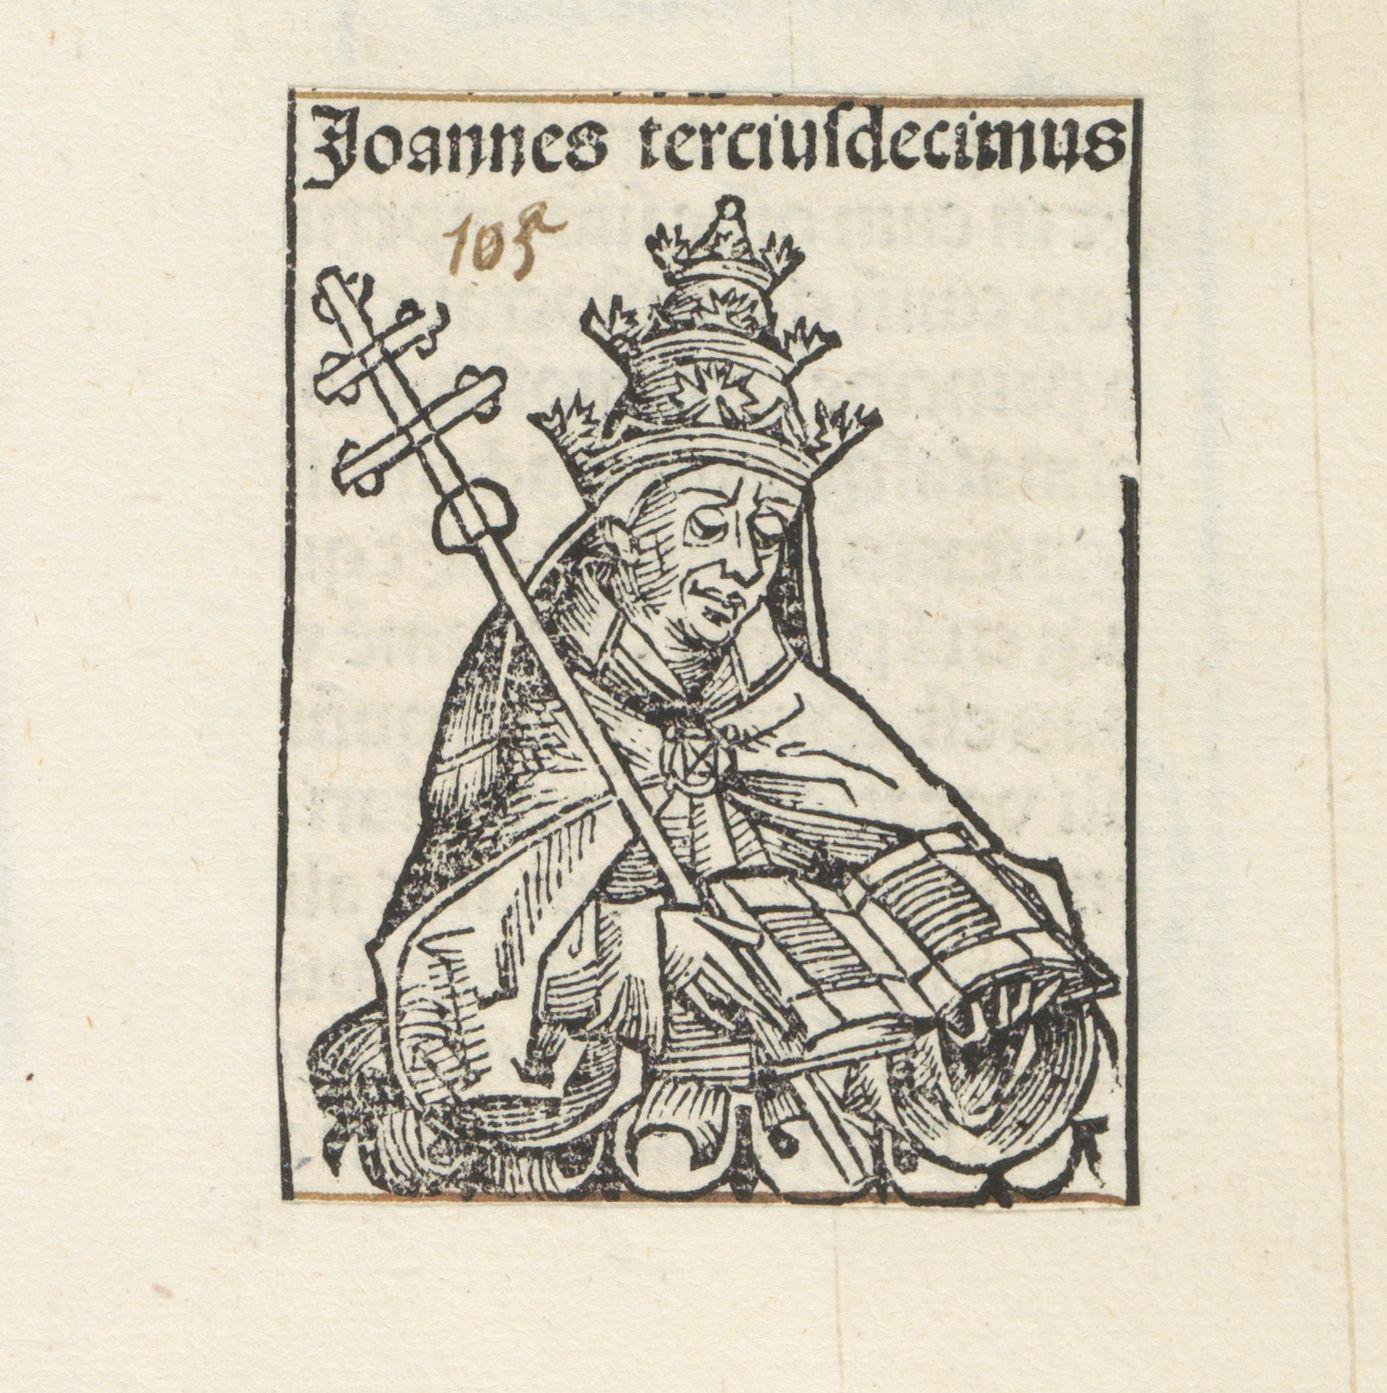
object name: book illustration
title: Liber Chronicarum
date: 1493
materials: paper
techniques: letterpress printing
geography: nuremberg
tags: rome, pope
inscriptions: inscription: ‘105’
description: Een bloemkelk met een paus. Hij draagt een tiara en heeft een opengeslagen bijbel en een staf met een dubbel kruis in zijn handen. De voorstelling is onderdeel van de opeenvolging pausen in de Liber Chronicarum. De tekst identificeert de man als Johannes XIII. De prent maakt deel uit van een album.